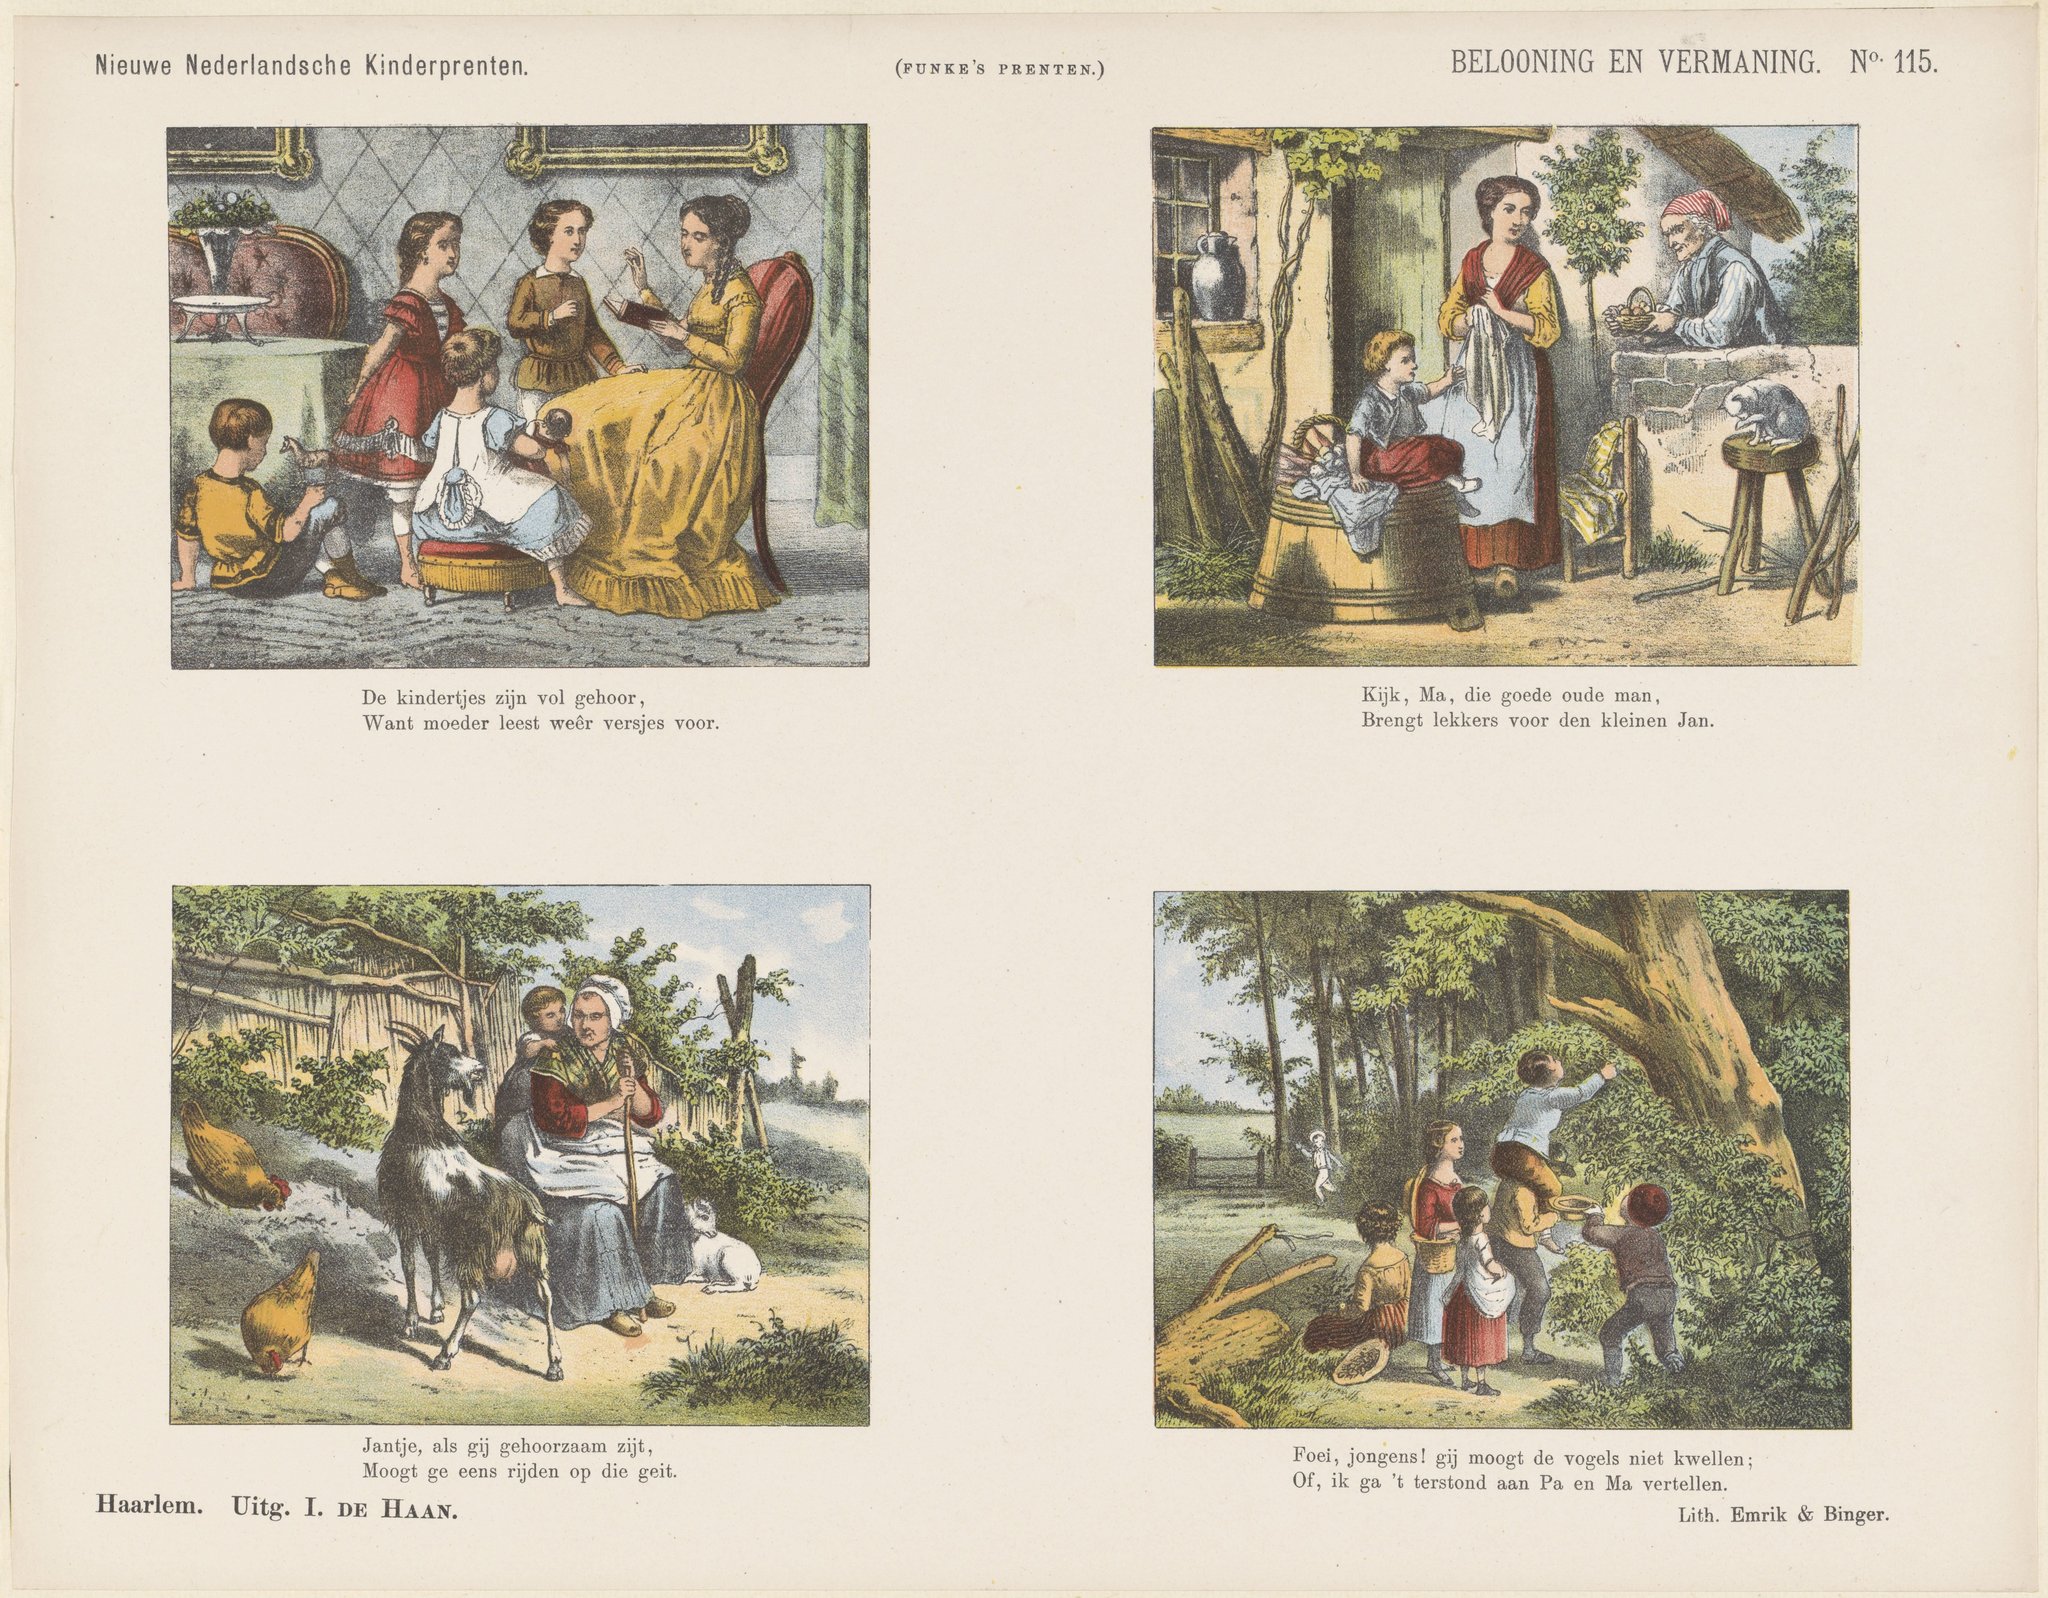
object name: popular print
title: Funke's prenten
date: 1875-1903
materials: paper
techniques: lithograph, letterpress printing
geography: haarlem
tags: story teller; listening to story teller, child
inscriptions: collector's mark: Lugt 2760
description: Blad met 4 voorstellingen van kindertaferelen, onder andere kinderen die luisteren naar hun moeder die voorleest en kinderen die vogels proberen te vangen. Onder elke voorstelling een tweeregelig vers. Genummerd rechtsboven: No. 115.